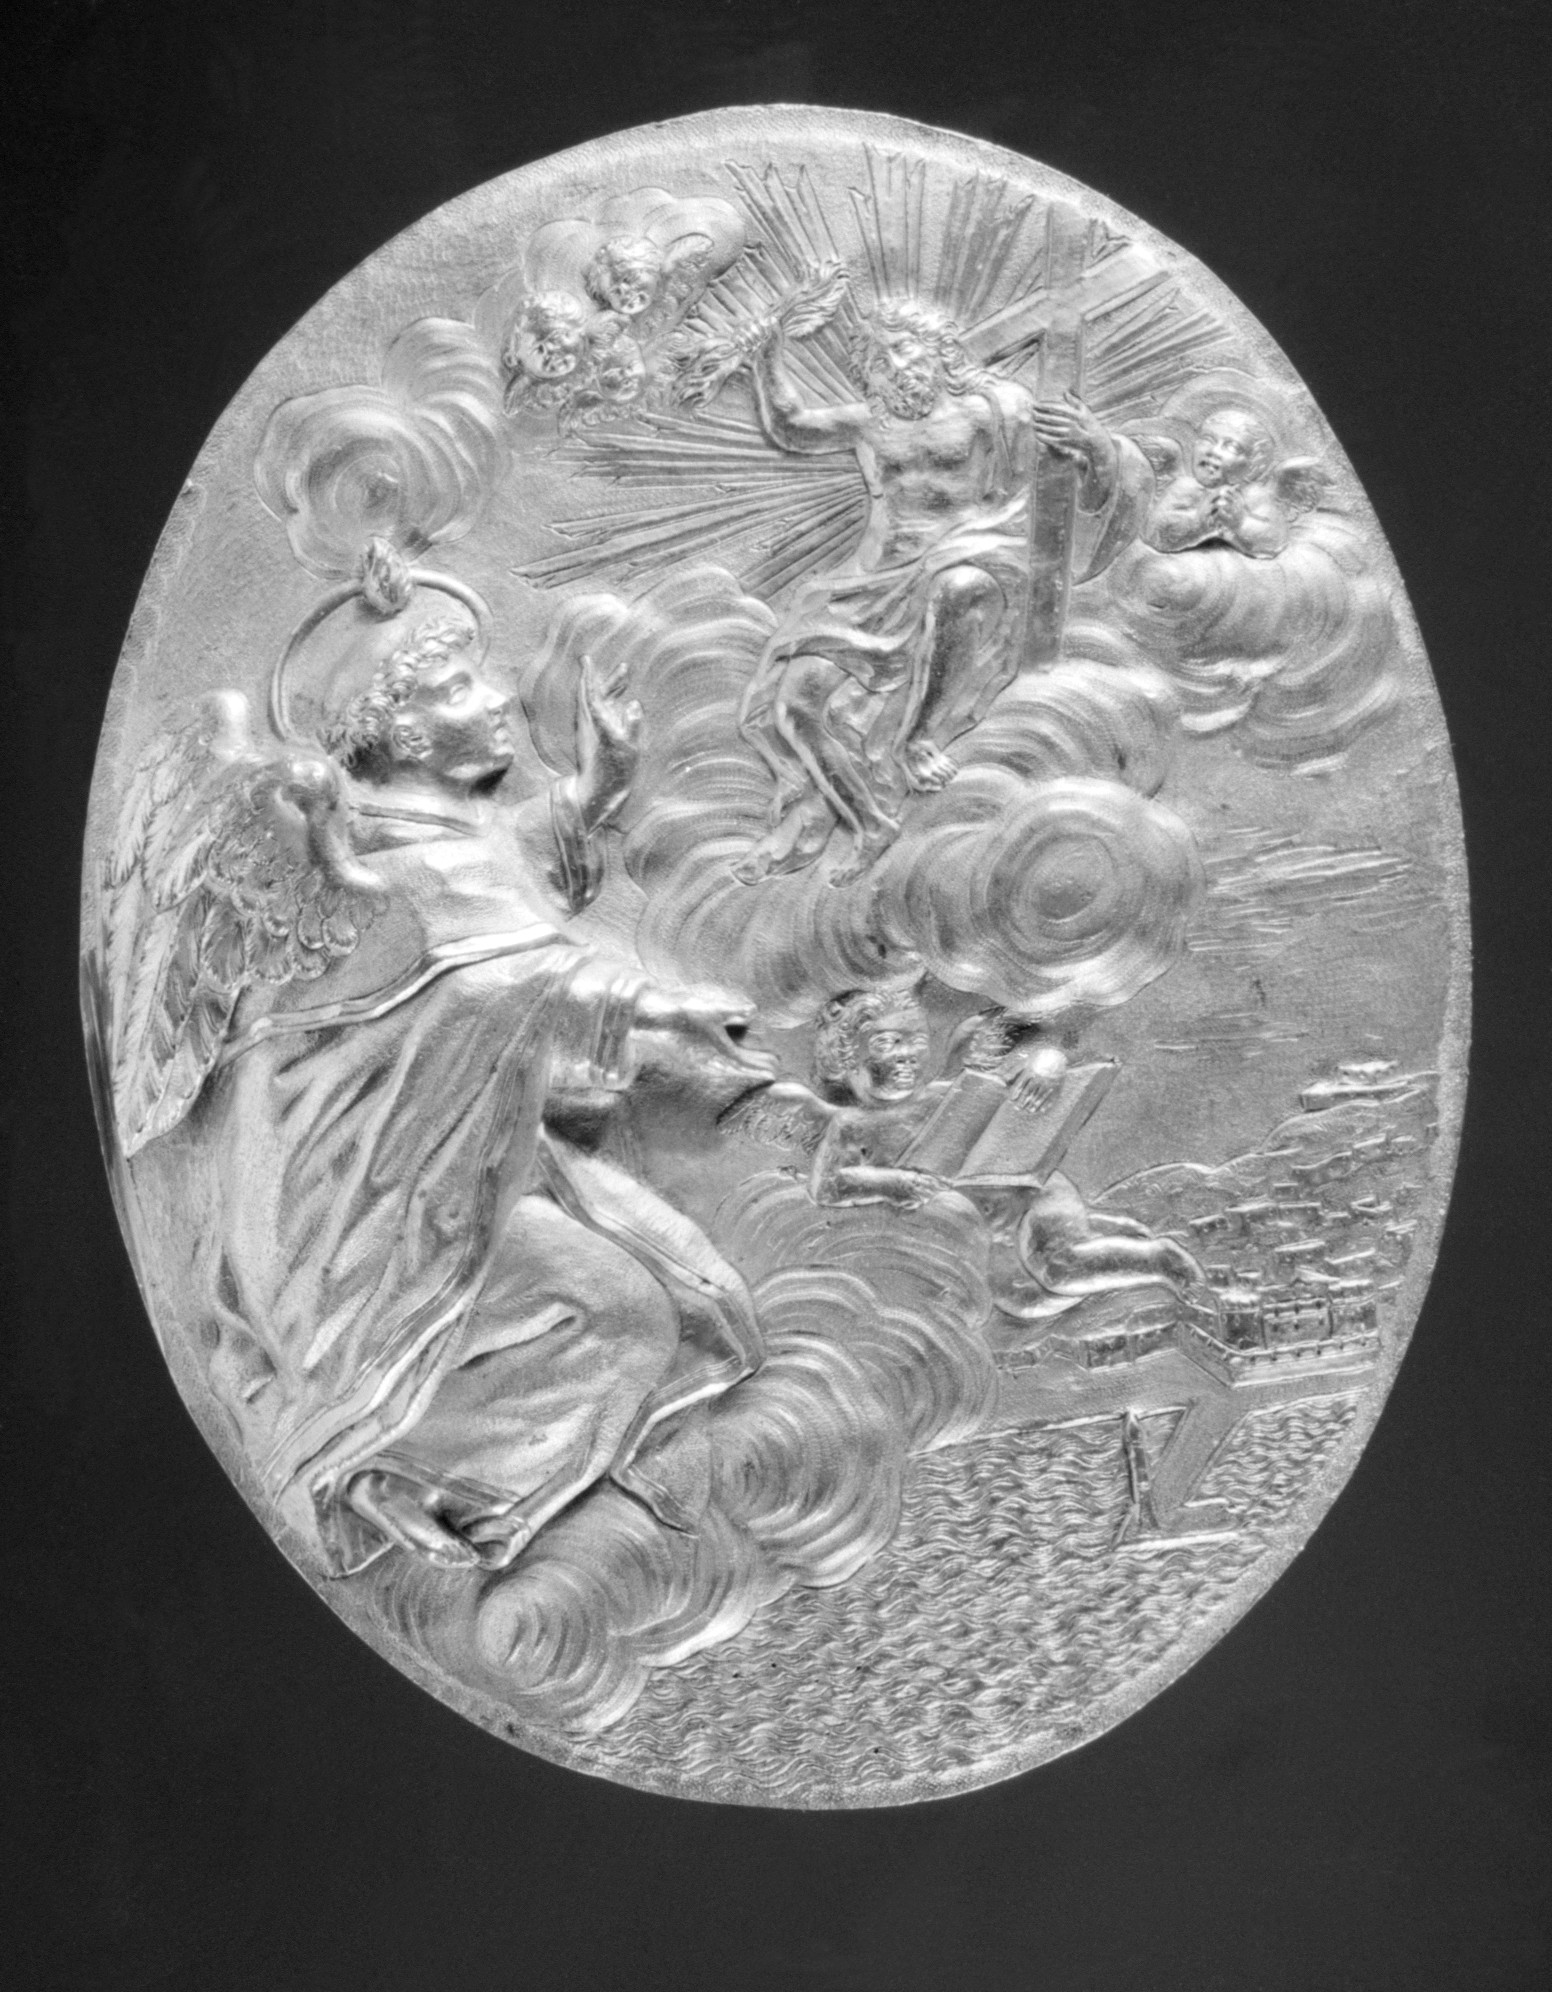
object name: plaquette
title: St. Vincent Ferrer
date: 1601-1700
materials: gilt bronze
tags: angels,cross,jesus,saints